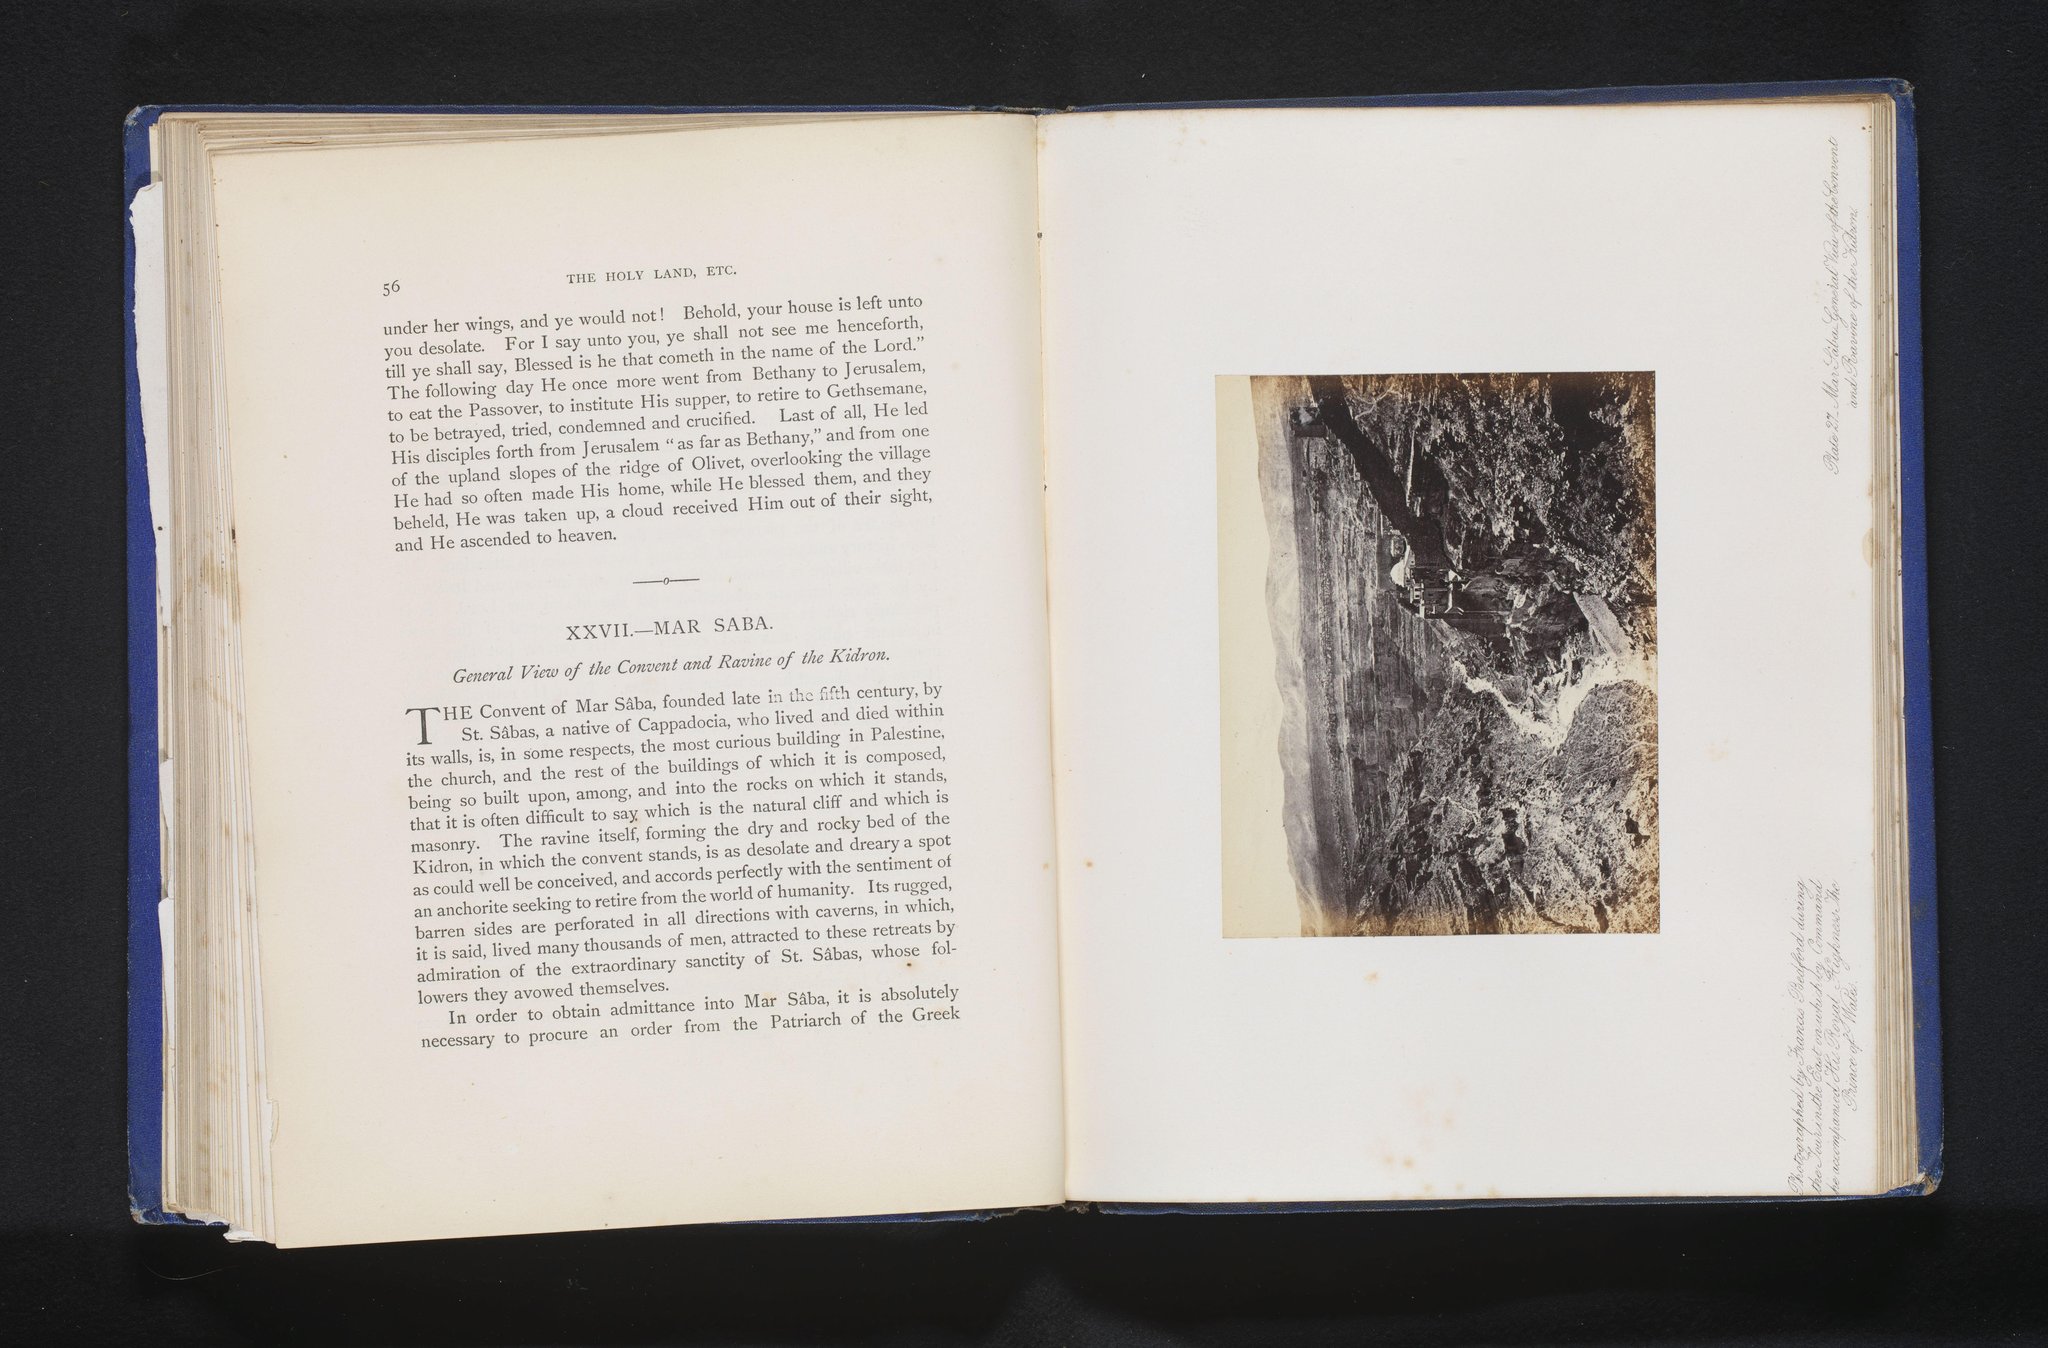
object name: photograph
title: Mar-Sâba-General view of the Convent and Ravine of the Kidron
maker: francis bedford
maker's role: print maker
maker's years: 1815-1894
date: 1861-1866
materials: photographic support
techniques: albumen print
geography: kidron valley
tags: dale, valley, abbey, monastery, convent ~ roman catholic church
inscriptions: inscription: ‘Photographed by Francis Bedford during the Tour in the East on which by Command he accompanied His Royal Highness The Prince of Wales’, number: ‘Plate 27.’